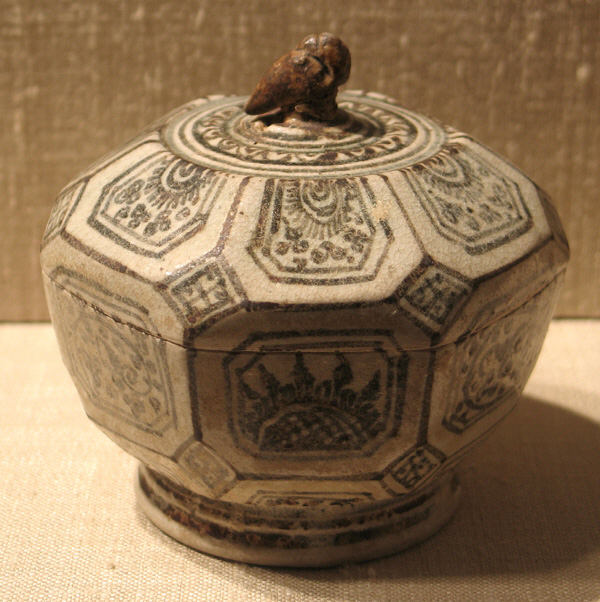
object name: covered box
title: Hexagonal Faceted Covered Box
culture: thai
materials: earthenware, glaze, iron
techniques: underglaze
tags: birds